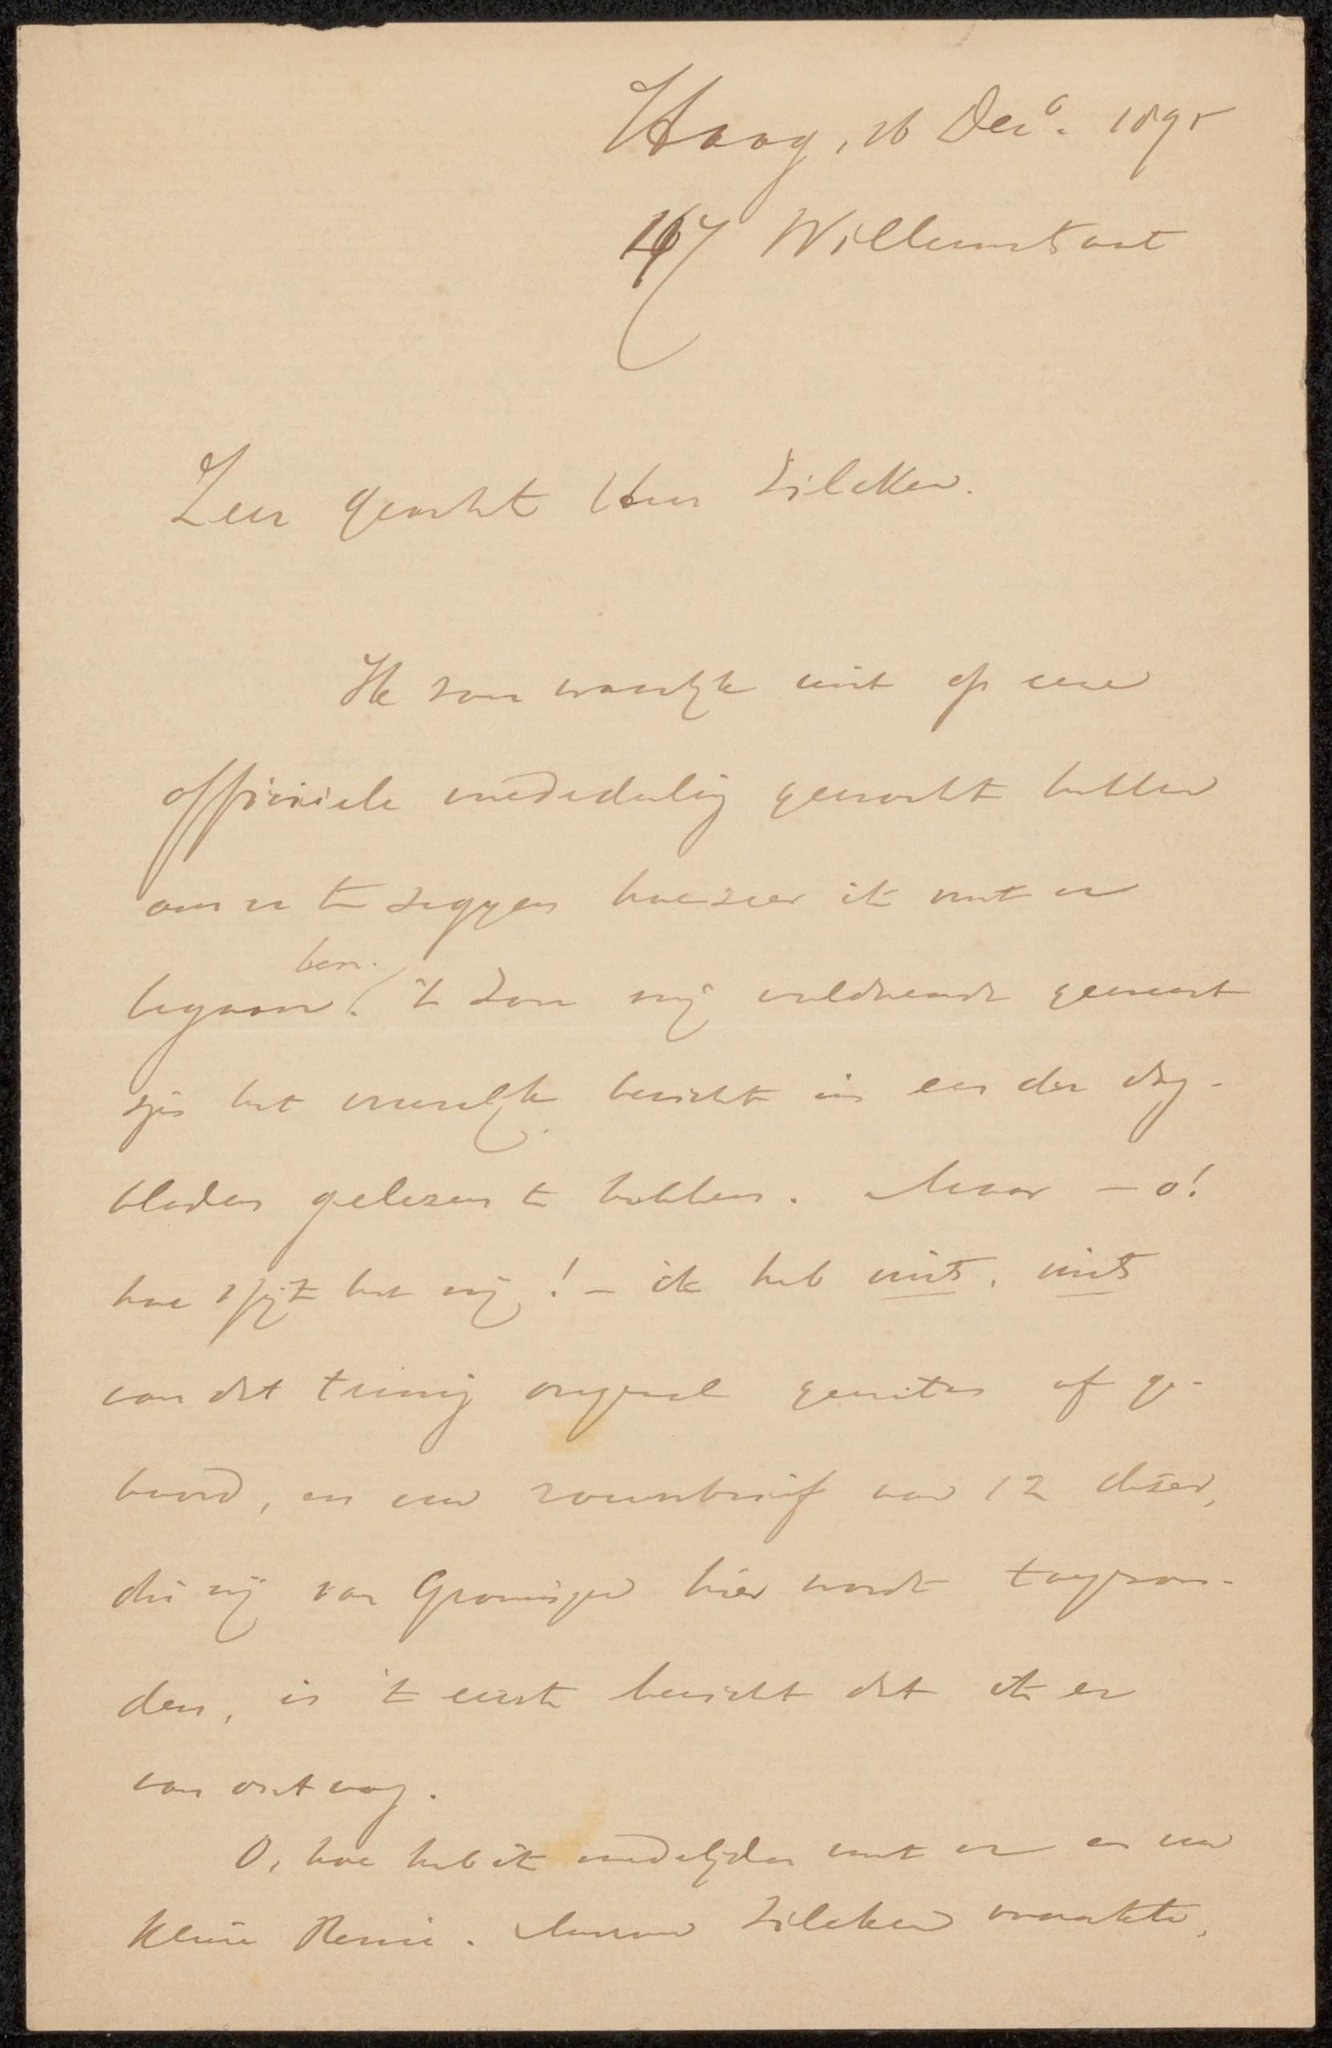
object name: letter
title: Brief aan Philip Zilcken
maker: antonius gerardus van hamel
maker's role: hoogleraar, theoloog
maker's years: 1842-1907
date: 1895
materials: ink, paper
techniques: pen, writing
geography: the hague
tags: voorburg, print maker, renée hélène laure zilcken, brussels, helène lambertine hauzeur, painter, philip zilcken, passions, emotions, affections, the hague